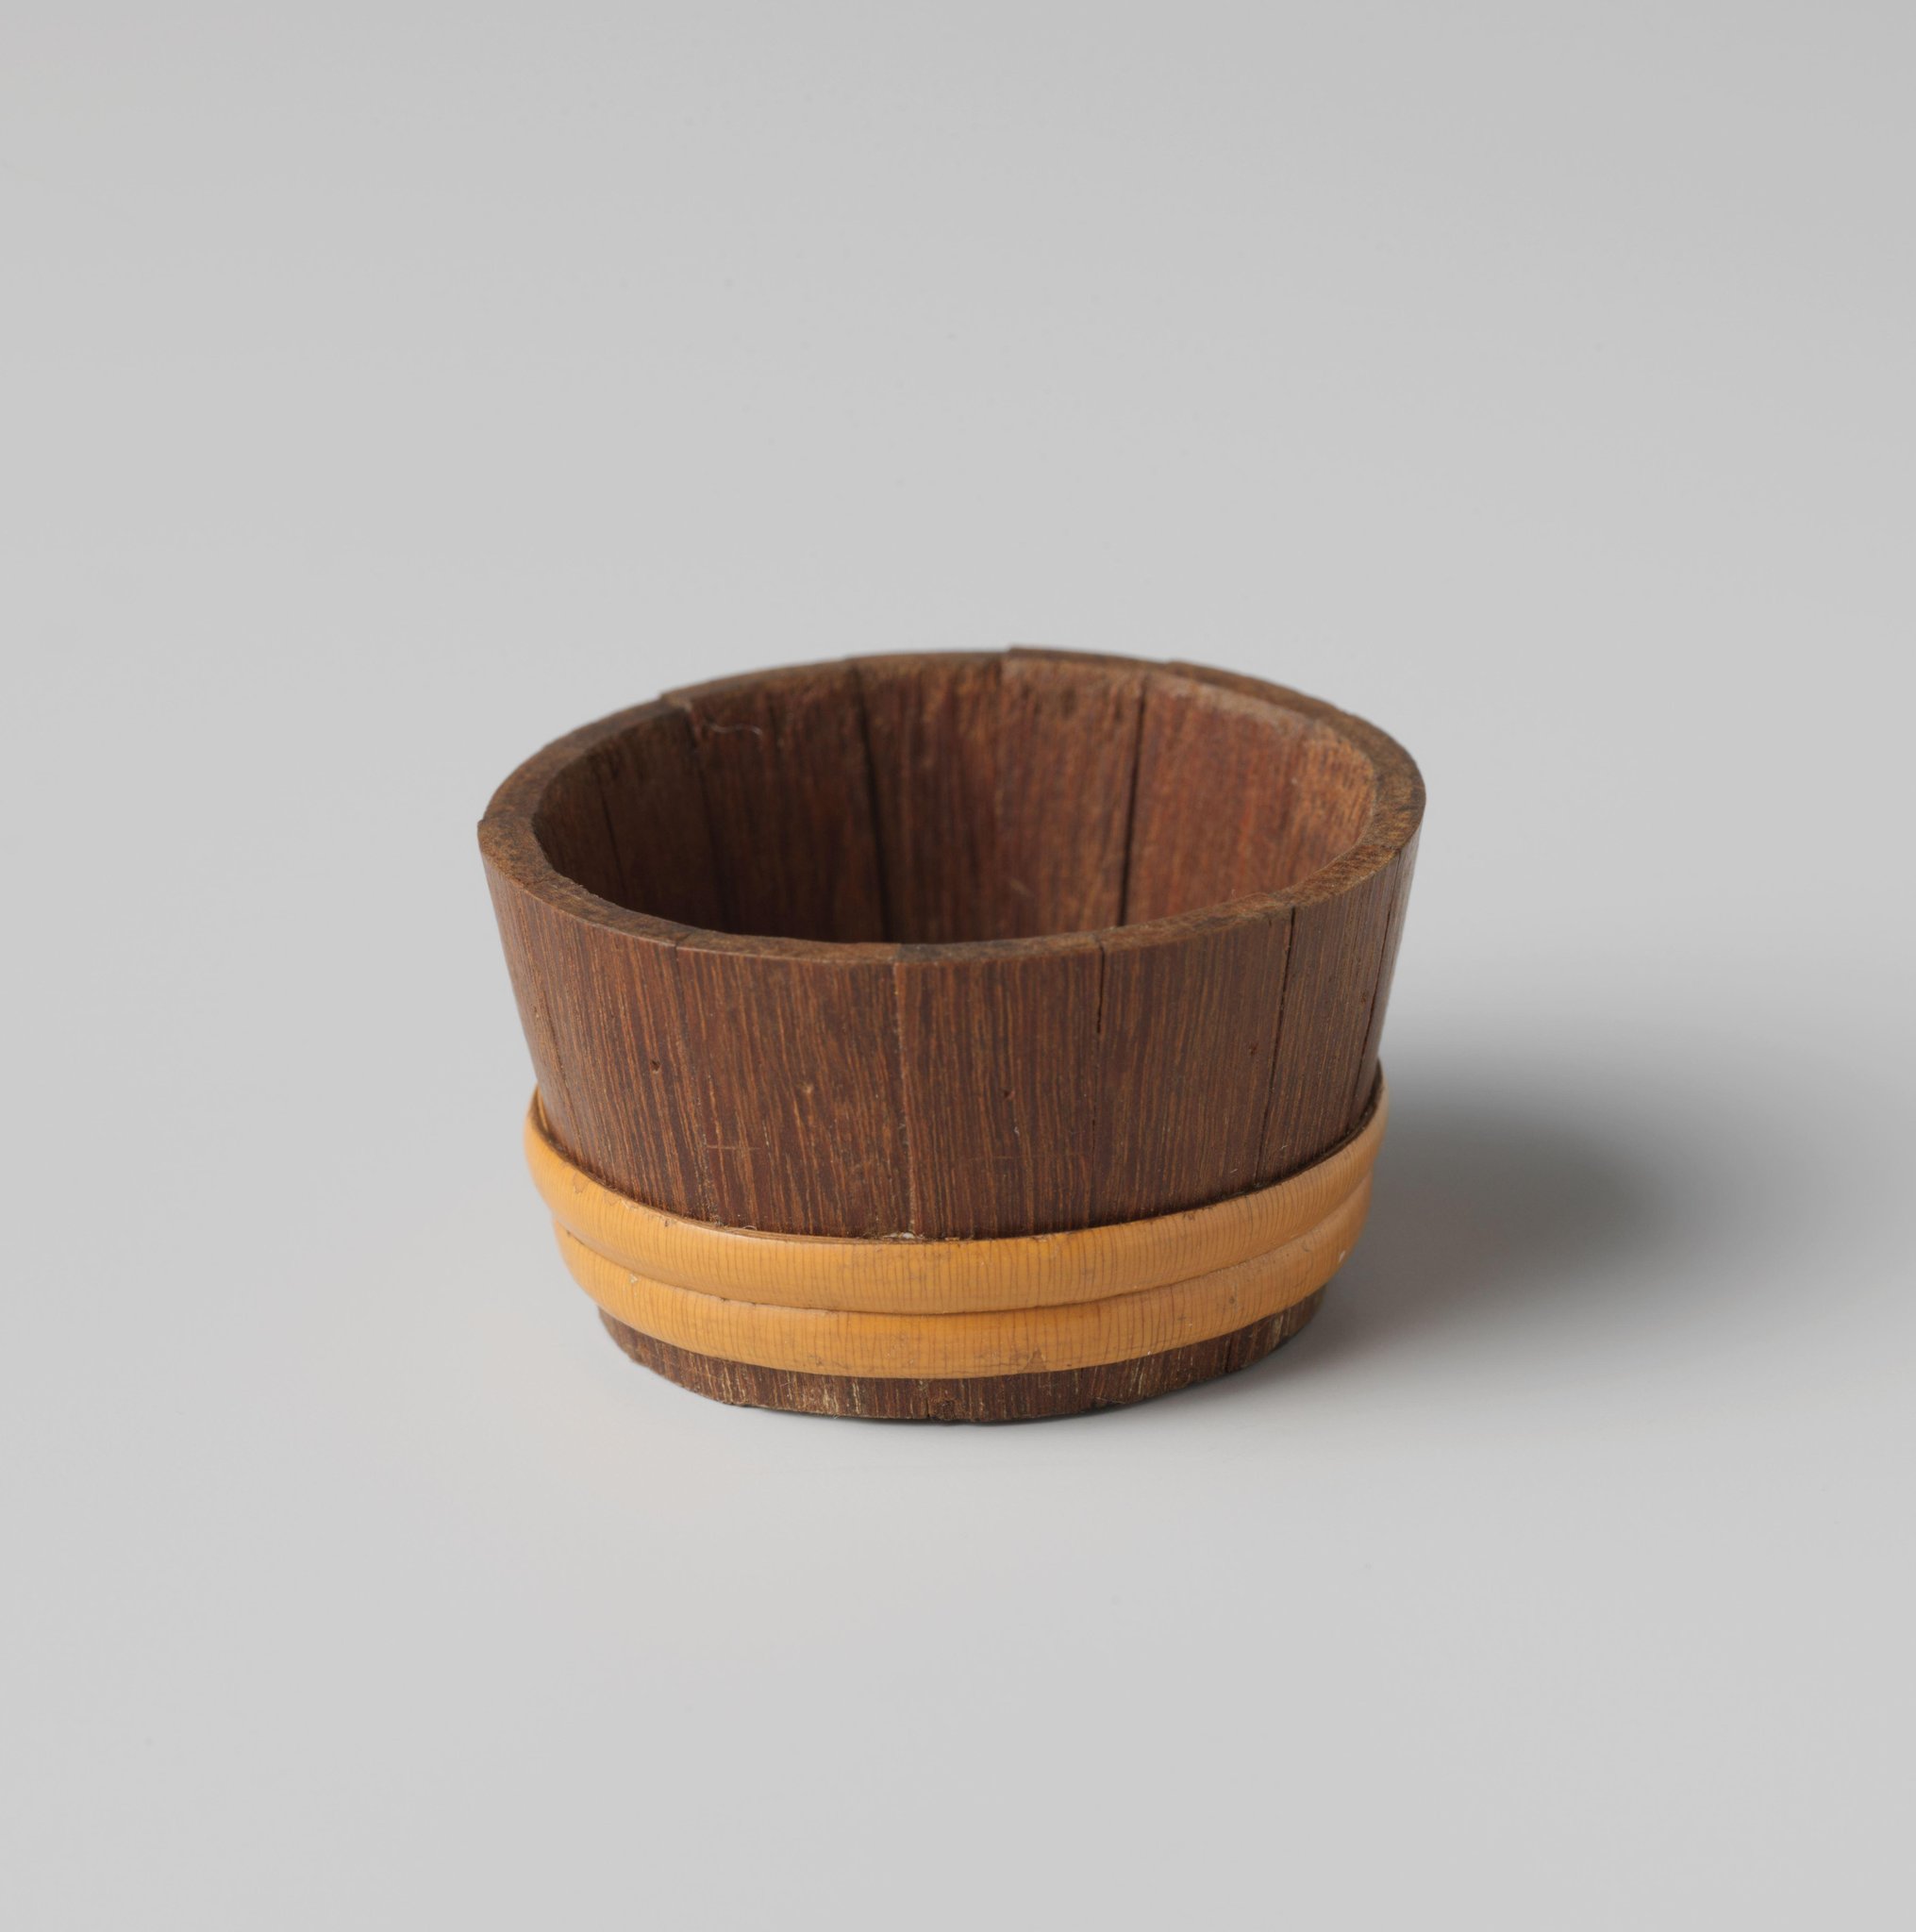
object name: miniature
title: Tobbe of standring, vervaardigd van duigen omwonden met twee en drie hoepels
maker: Anonymous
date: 1700-1799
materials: rattan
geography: amsterdam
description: Standring of bodemloze tobbe (lekbak), gemaakt van losse duigen van een tropische hardhoutsoort (bolletrie ?) omwonden door twee en drie hoepels van rotan.